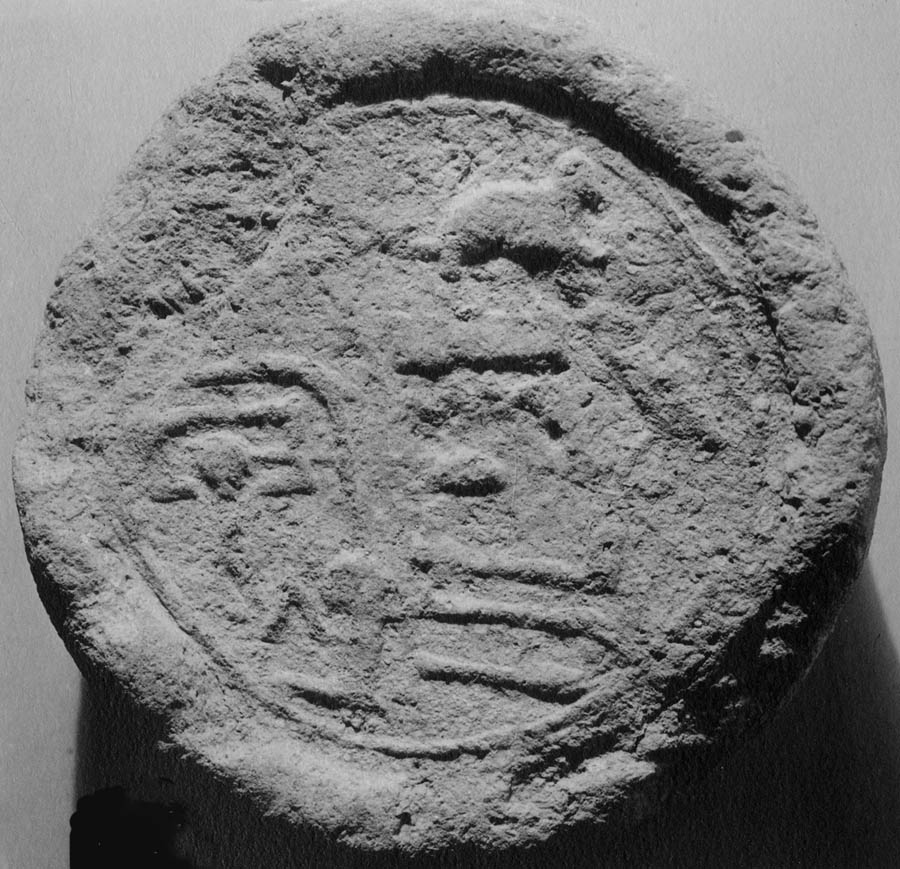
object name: cone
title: Funerary Cone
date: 1550-1295 BCE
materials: pottery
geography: egypt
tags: hieroglyphs